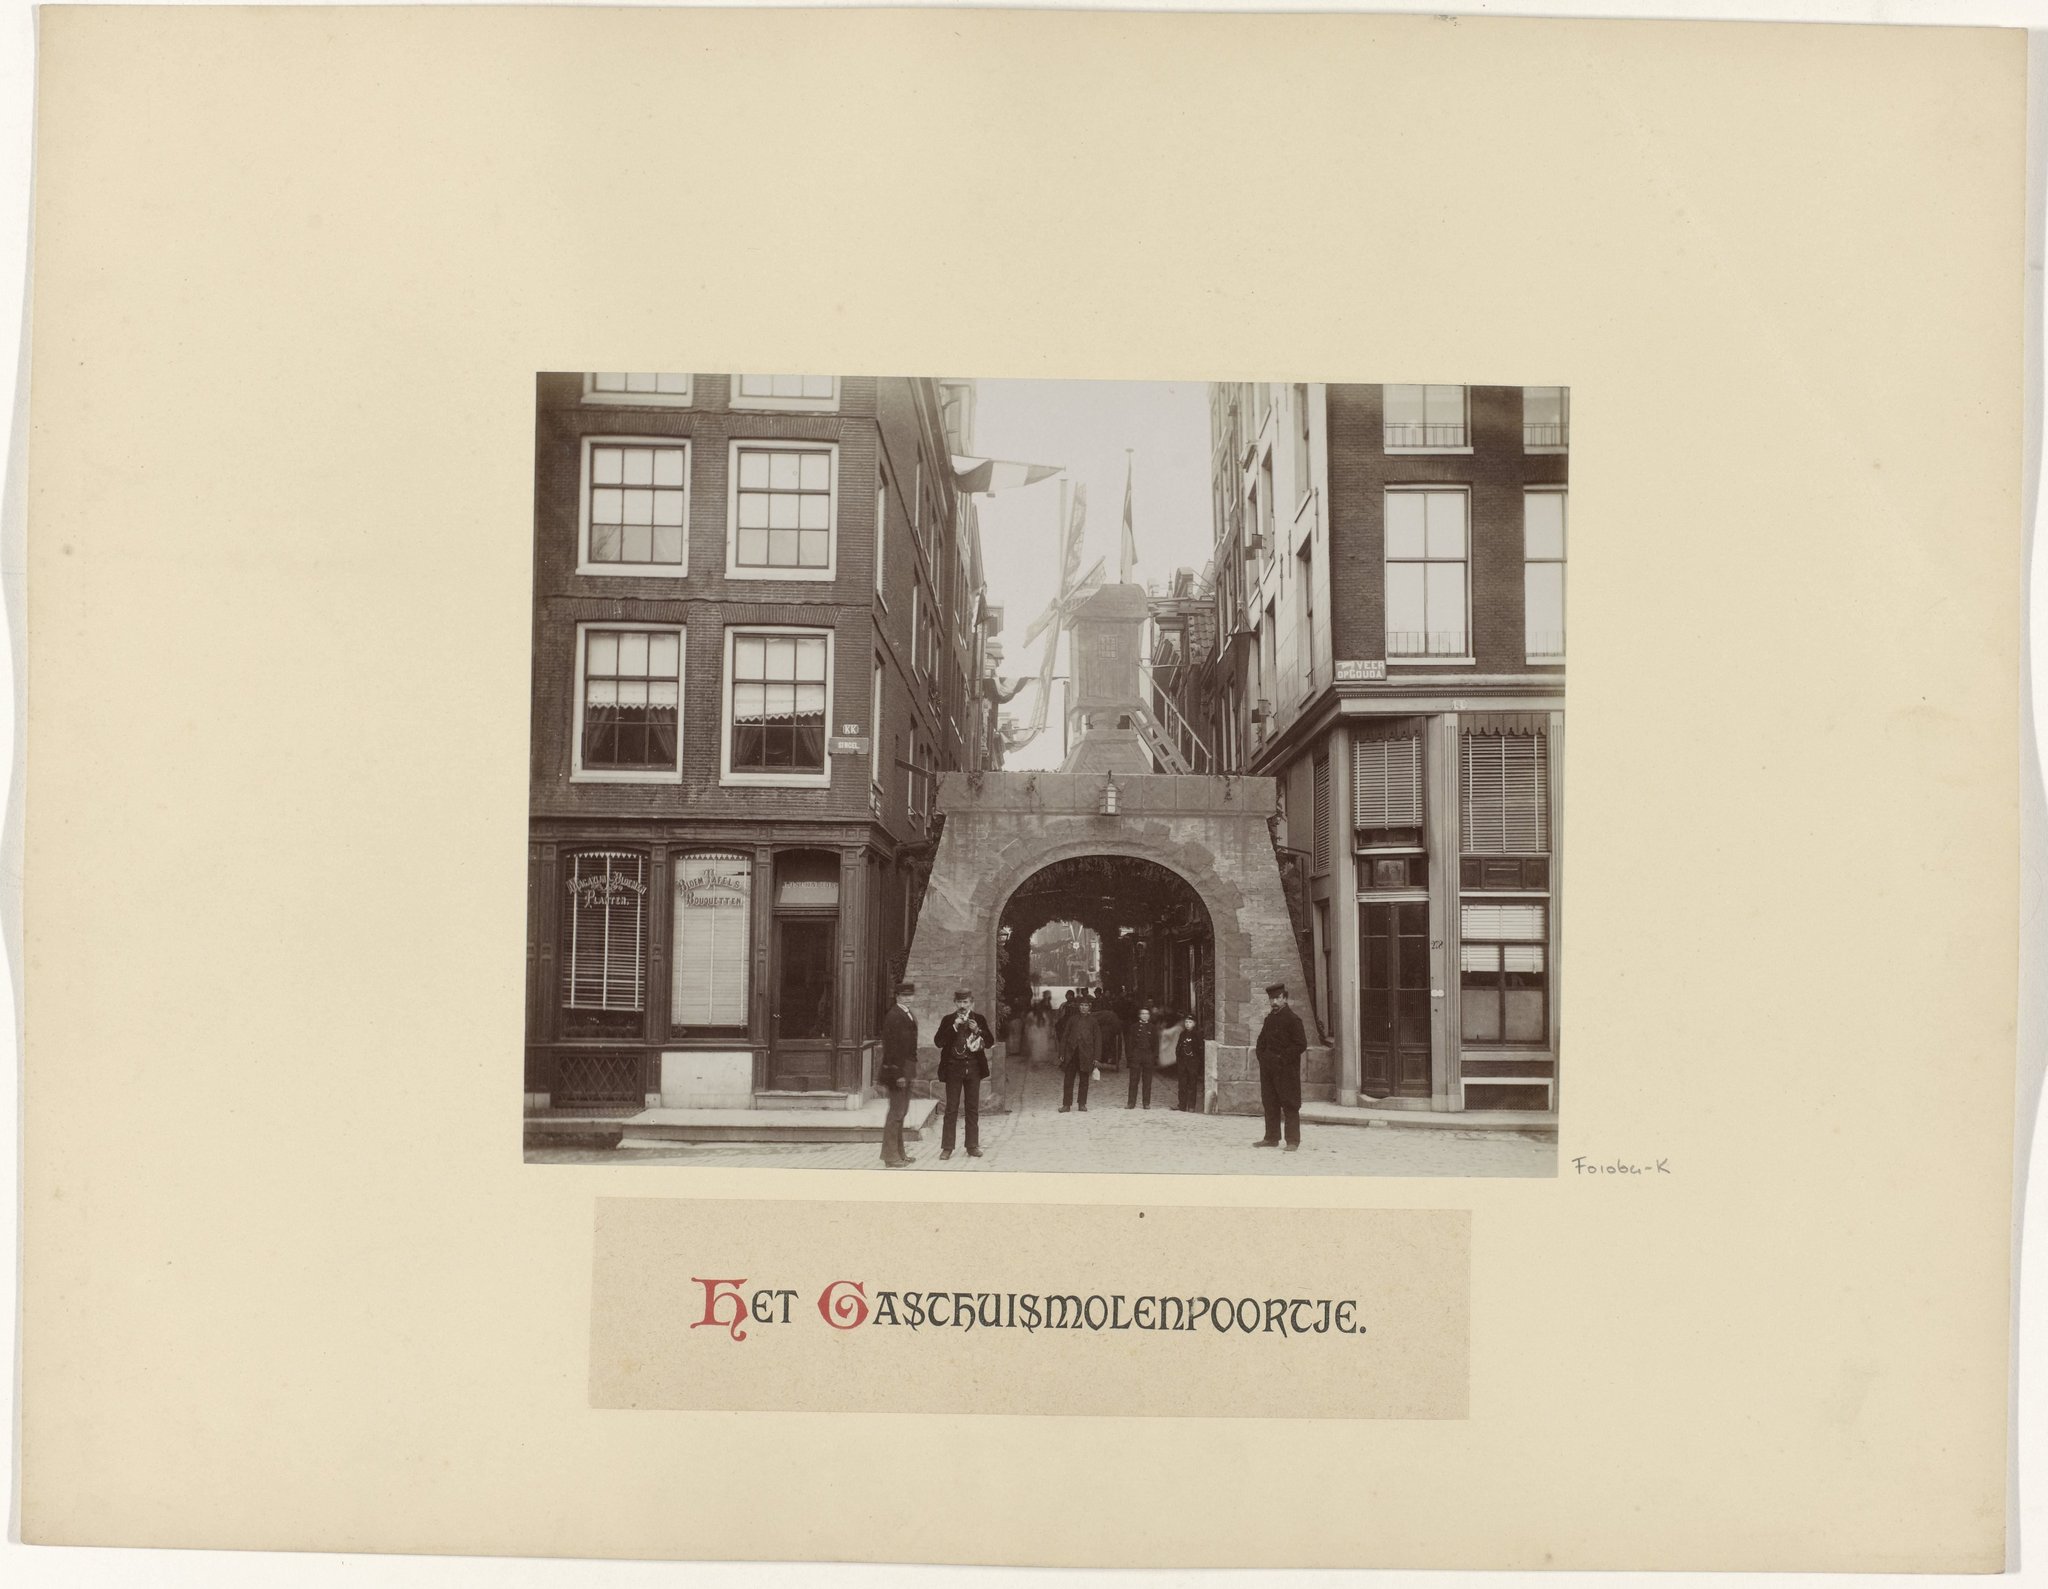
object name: photograph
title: Ereboog in de Gasthuismolensteeg tijdens de Aprilfeesten van 1887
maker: henri de louw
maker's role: fotograaf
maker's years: 1851-1944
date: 1887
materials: cardboard, paper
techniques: albumen print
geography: amsterdam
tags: public festivities on the occasion of royal events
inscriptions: inscription: ‘Het Gasthuismolenpoortje’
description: Deze foto maakt deel uit van een omslag met twaalf foto's.